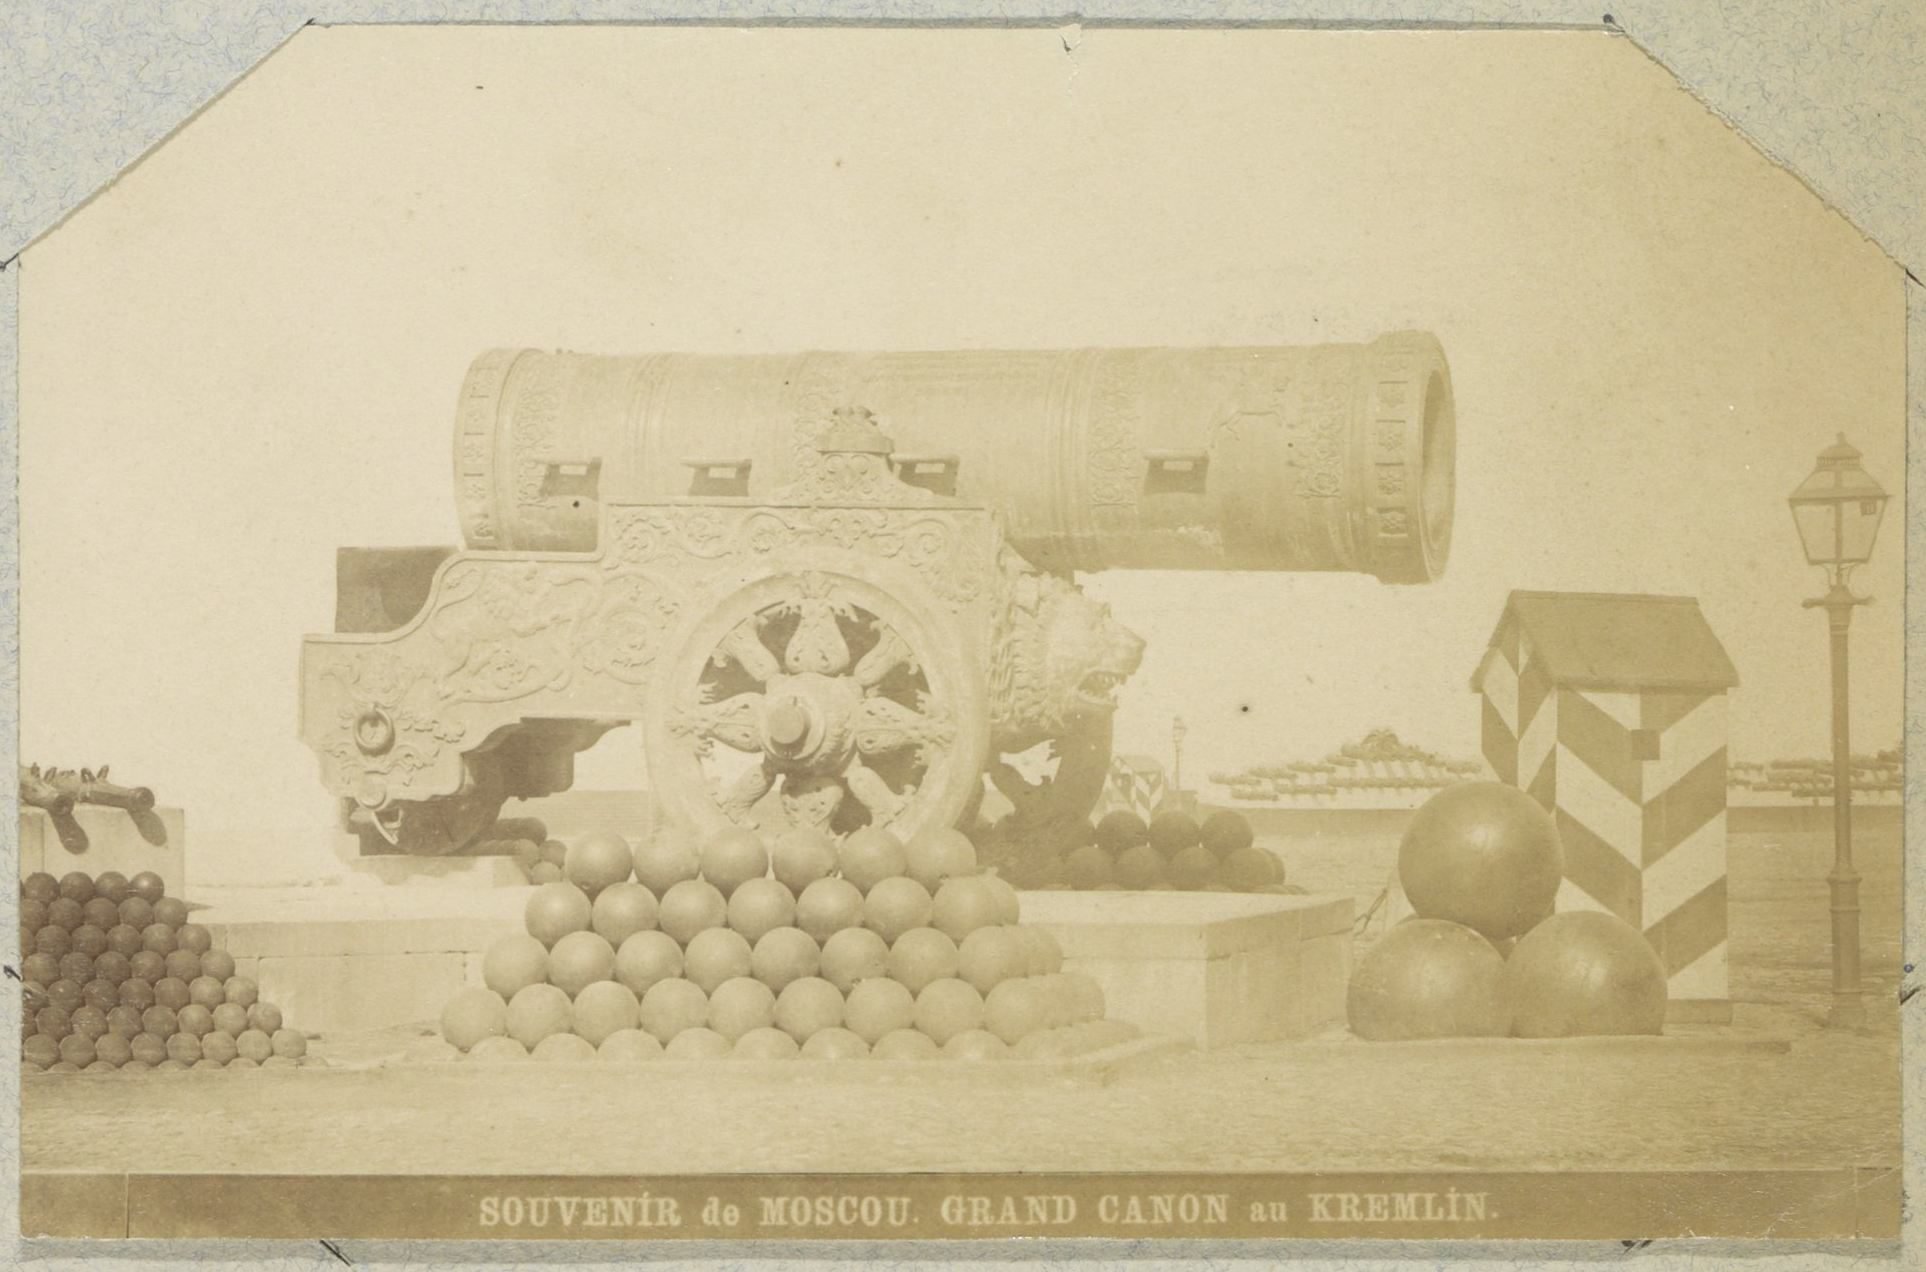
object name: album leaf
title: Souvenir de Moscou. Grand canon au Kremlin.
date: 1890-1900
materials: paper, photographic support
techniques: albumen print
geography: moscow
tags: firearms: cannon, projectiles, explosives, etc.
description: Onderdeel van Album van een Franse amateur met foto's van Frankrijk, Algerije, Palmyra, de Wereldtentoonstelling van 1900 en van bekende Fransen.